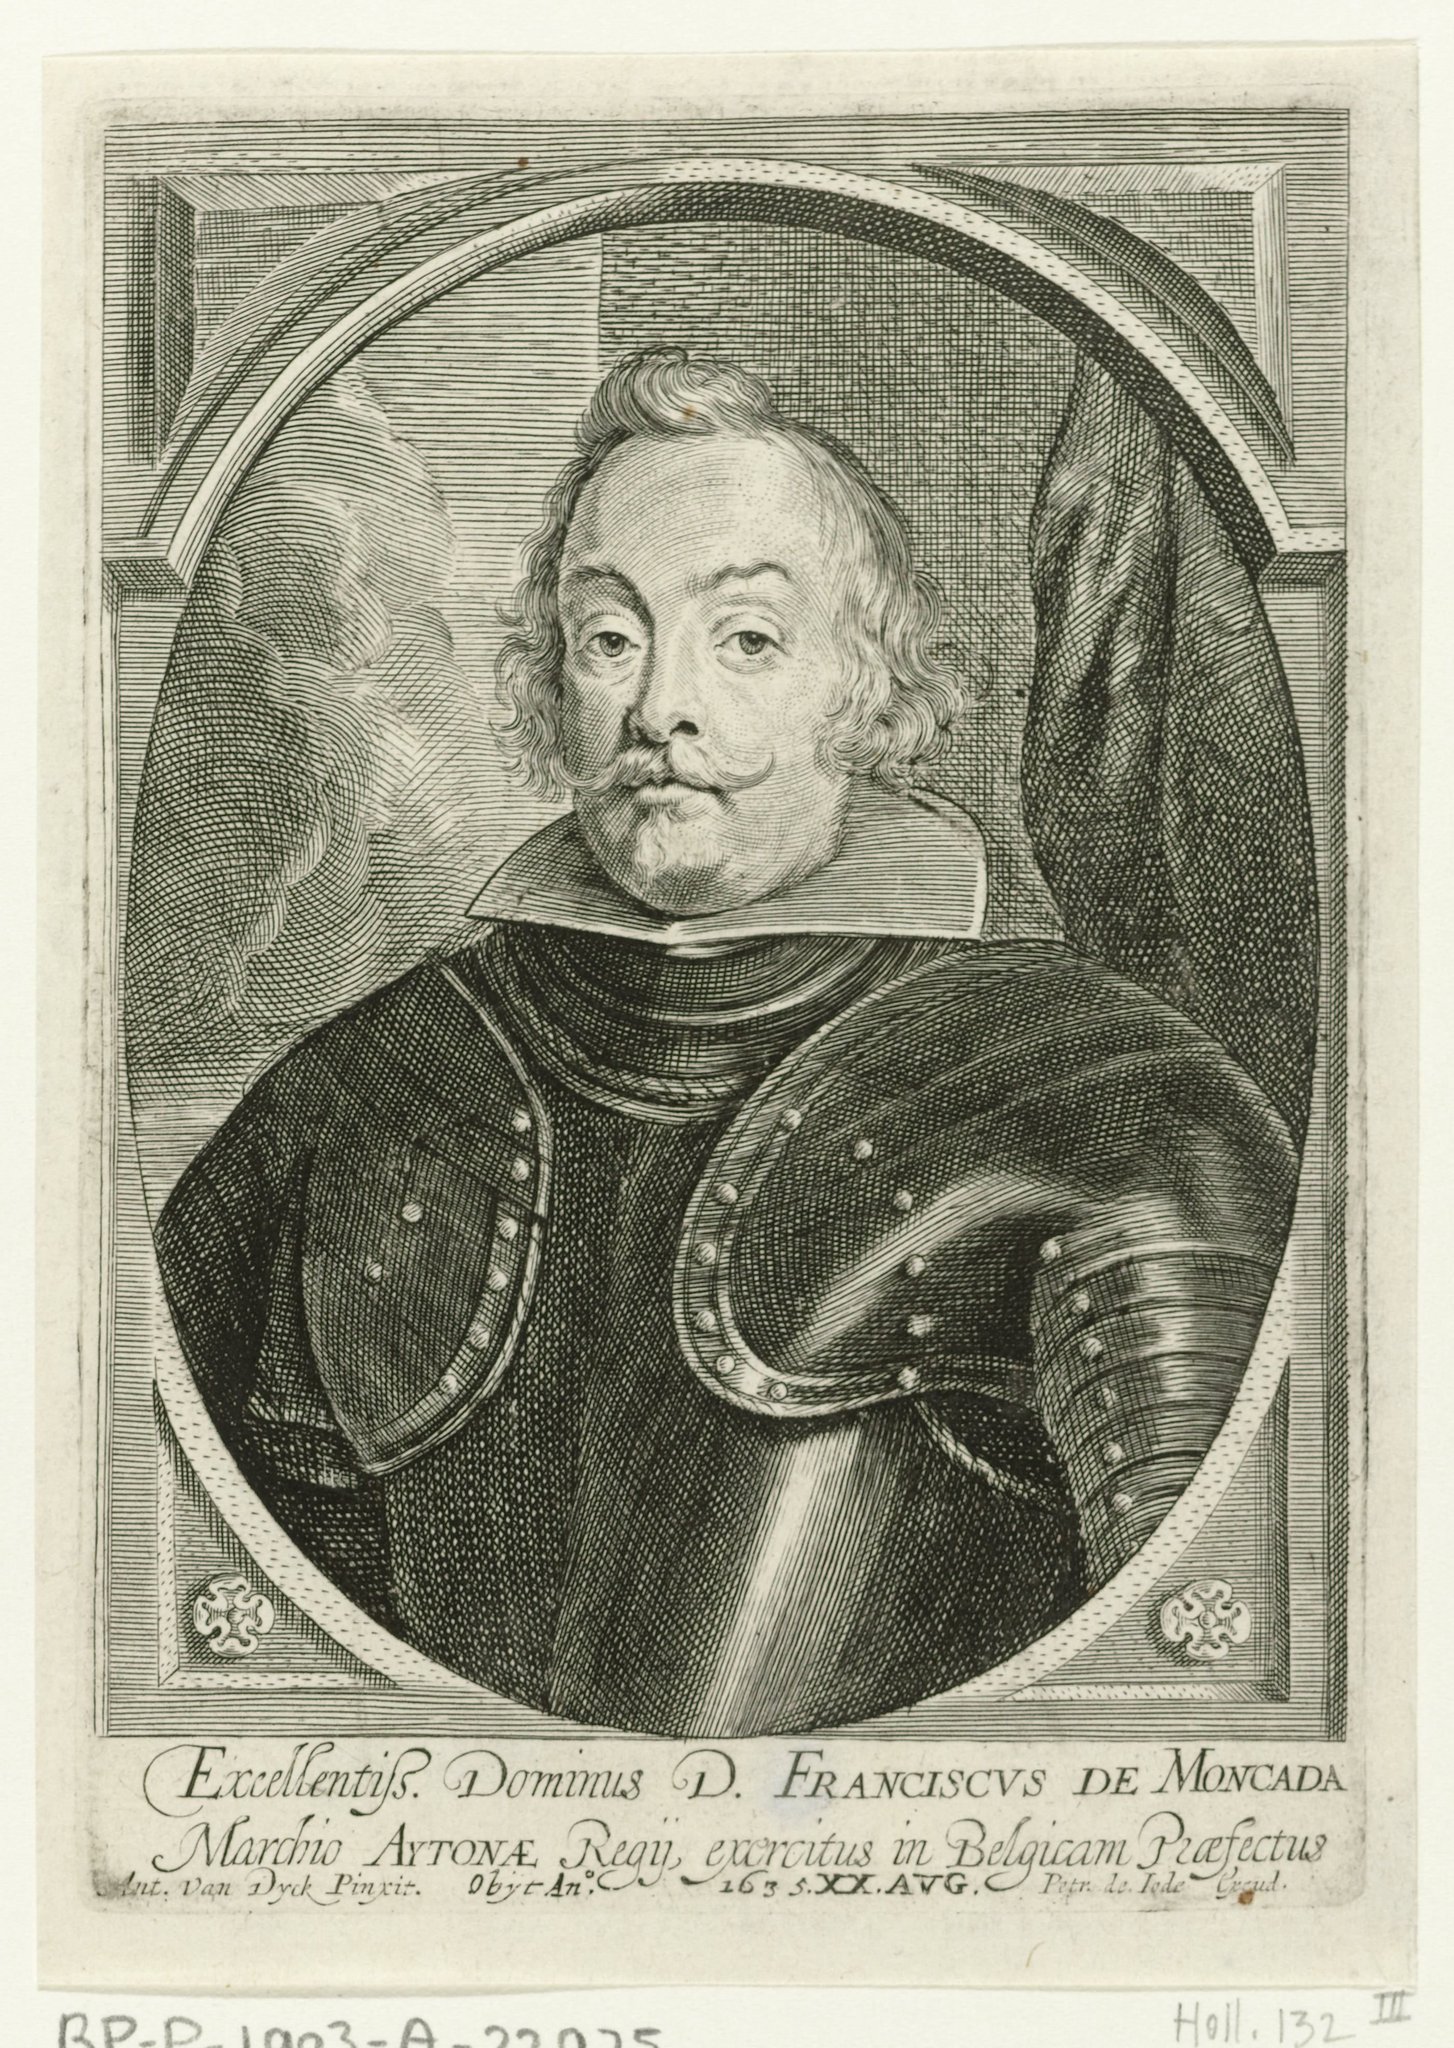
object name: print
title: Theater van bisschoppen, keizers, koningen, hertogen, prinsen, enz.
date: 1628-1670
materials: paper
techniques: engraving, etching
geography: antwerp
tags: brussels, francisco de moncada (markies van aytona), armour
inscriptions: collector's mark: Lugt 2228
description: Busteportret van Francisco de Moncada, in harnas. Het portret is gevat in een ovale omlijsting met vierkant randwerk met rozetten. In de marge een drieregelig onderschrift in het Latijn.